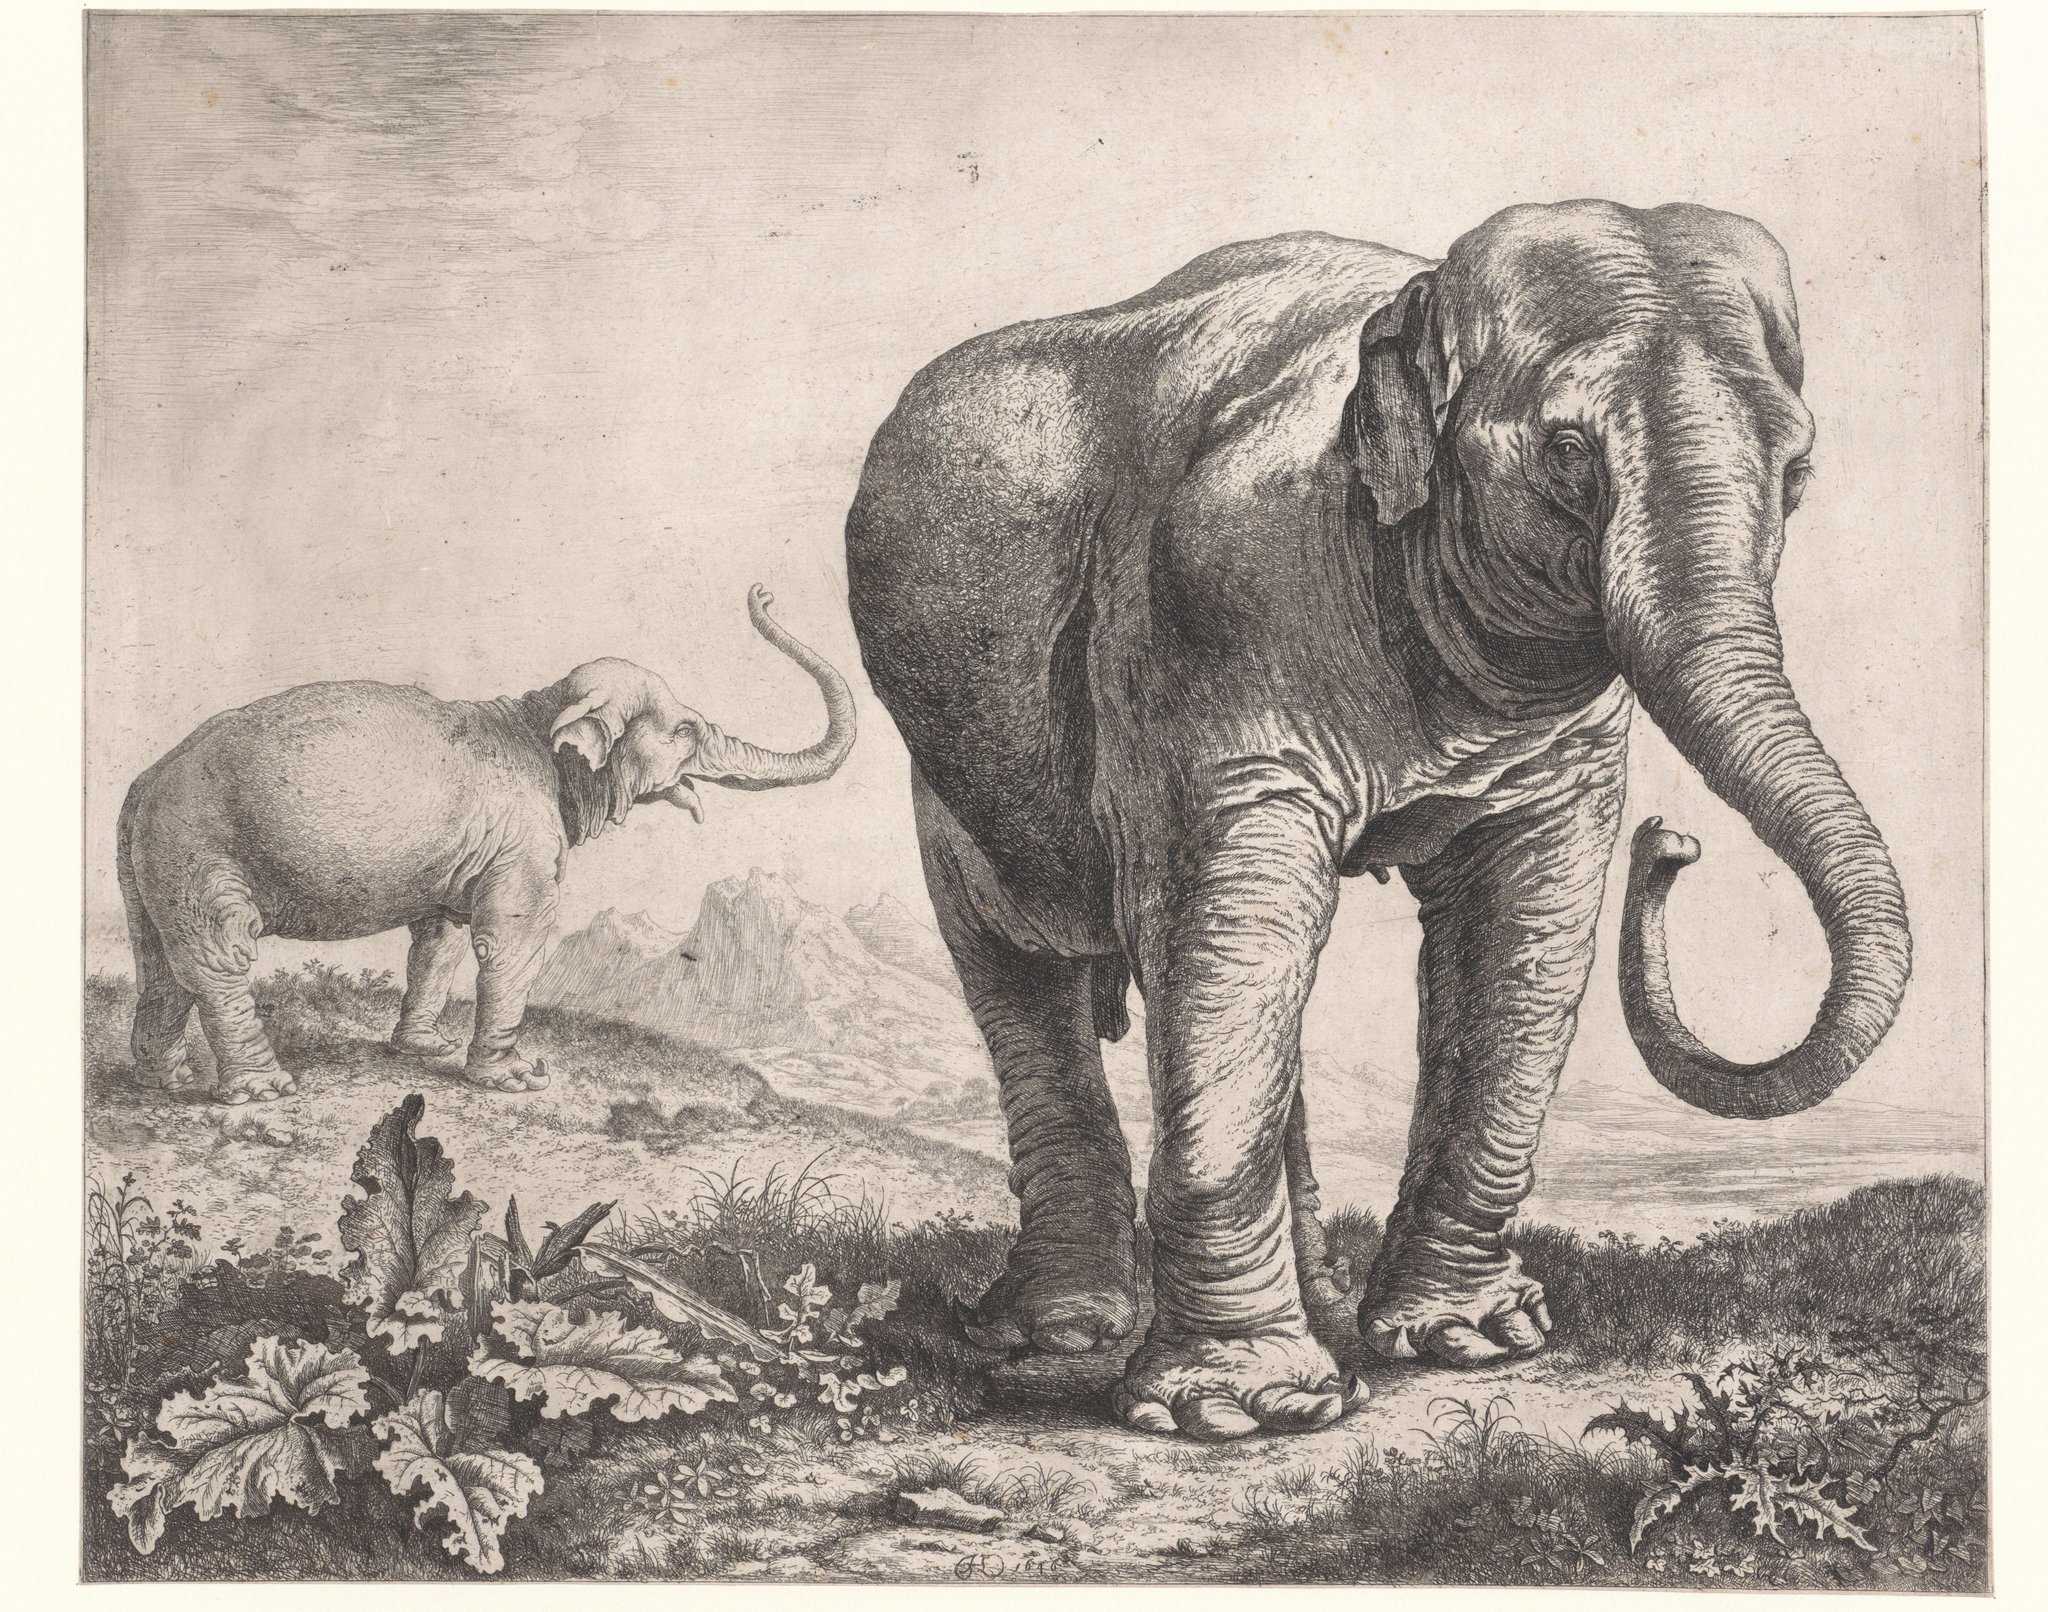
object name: print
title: Twee olifanten in een landschap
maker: herman saftleven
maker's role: draughtsman, painter, print maker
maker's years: 1609-1685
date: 1646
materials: paper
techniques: drypoint, etching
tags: landscapes, trunked animals: elephant, mountains - hh - ideal landscapes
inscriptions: collector's mark: Lugt 240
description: Gezicht op een landschap met op de voorgrond twee olifanten. Op de achtergrond zijn bergen te zien.